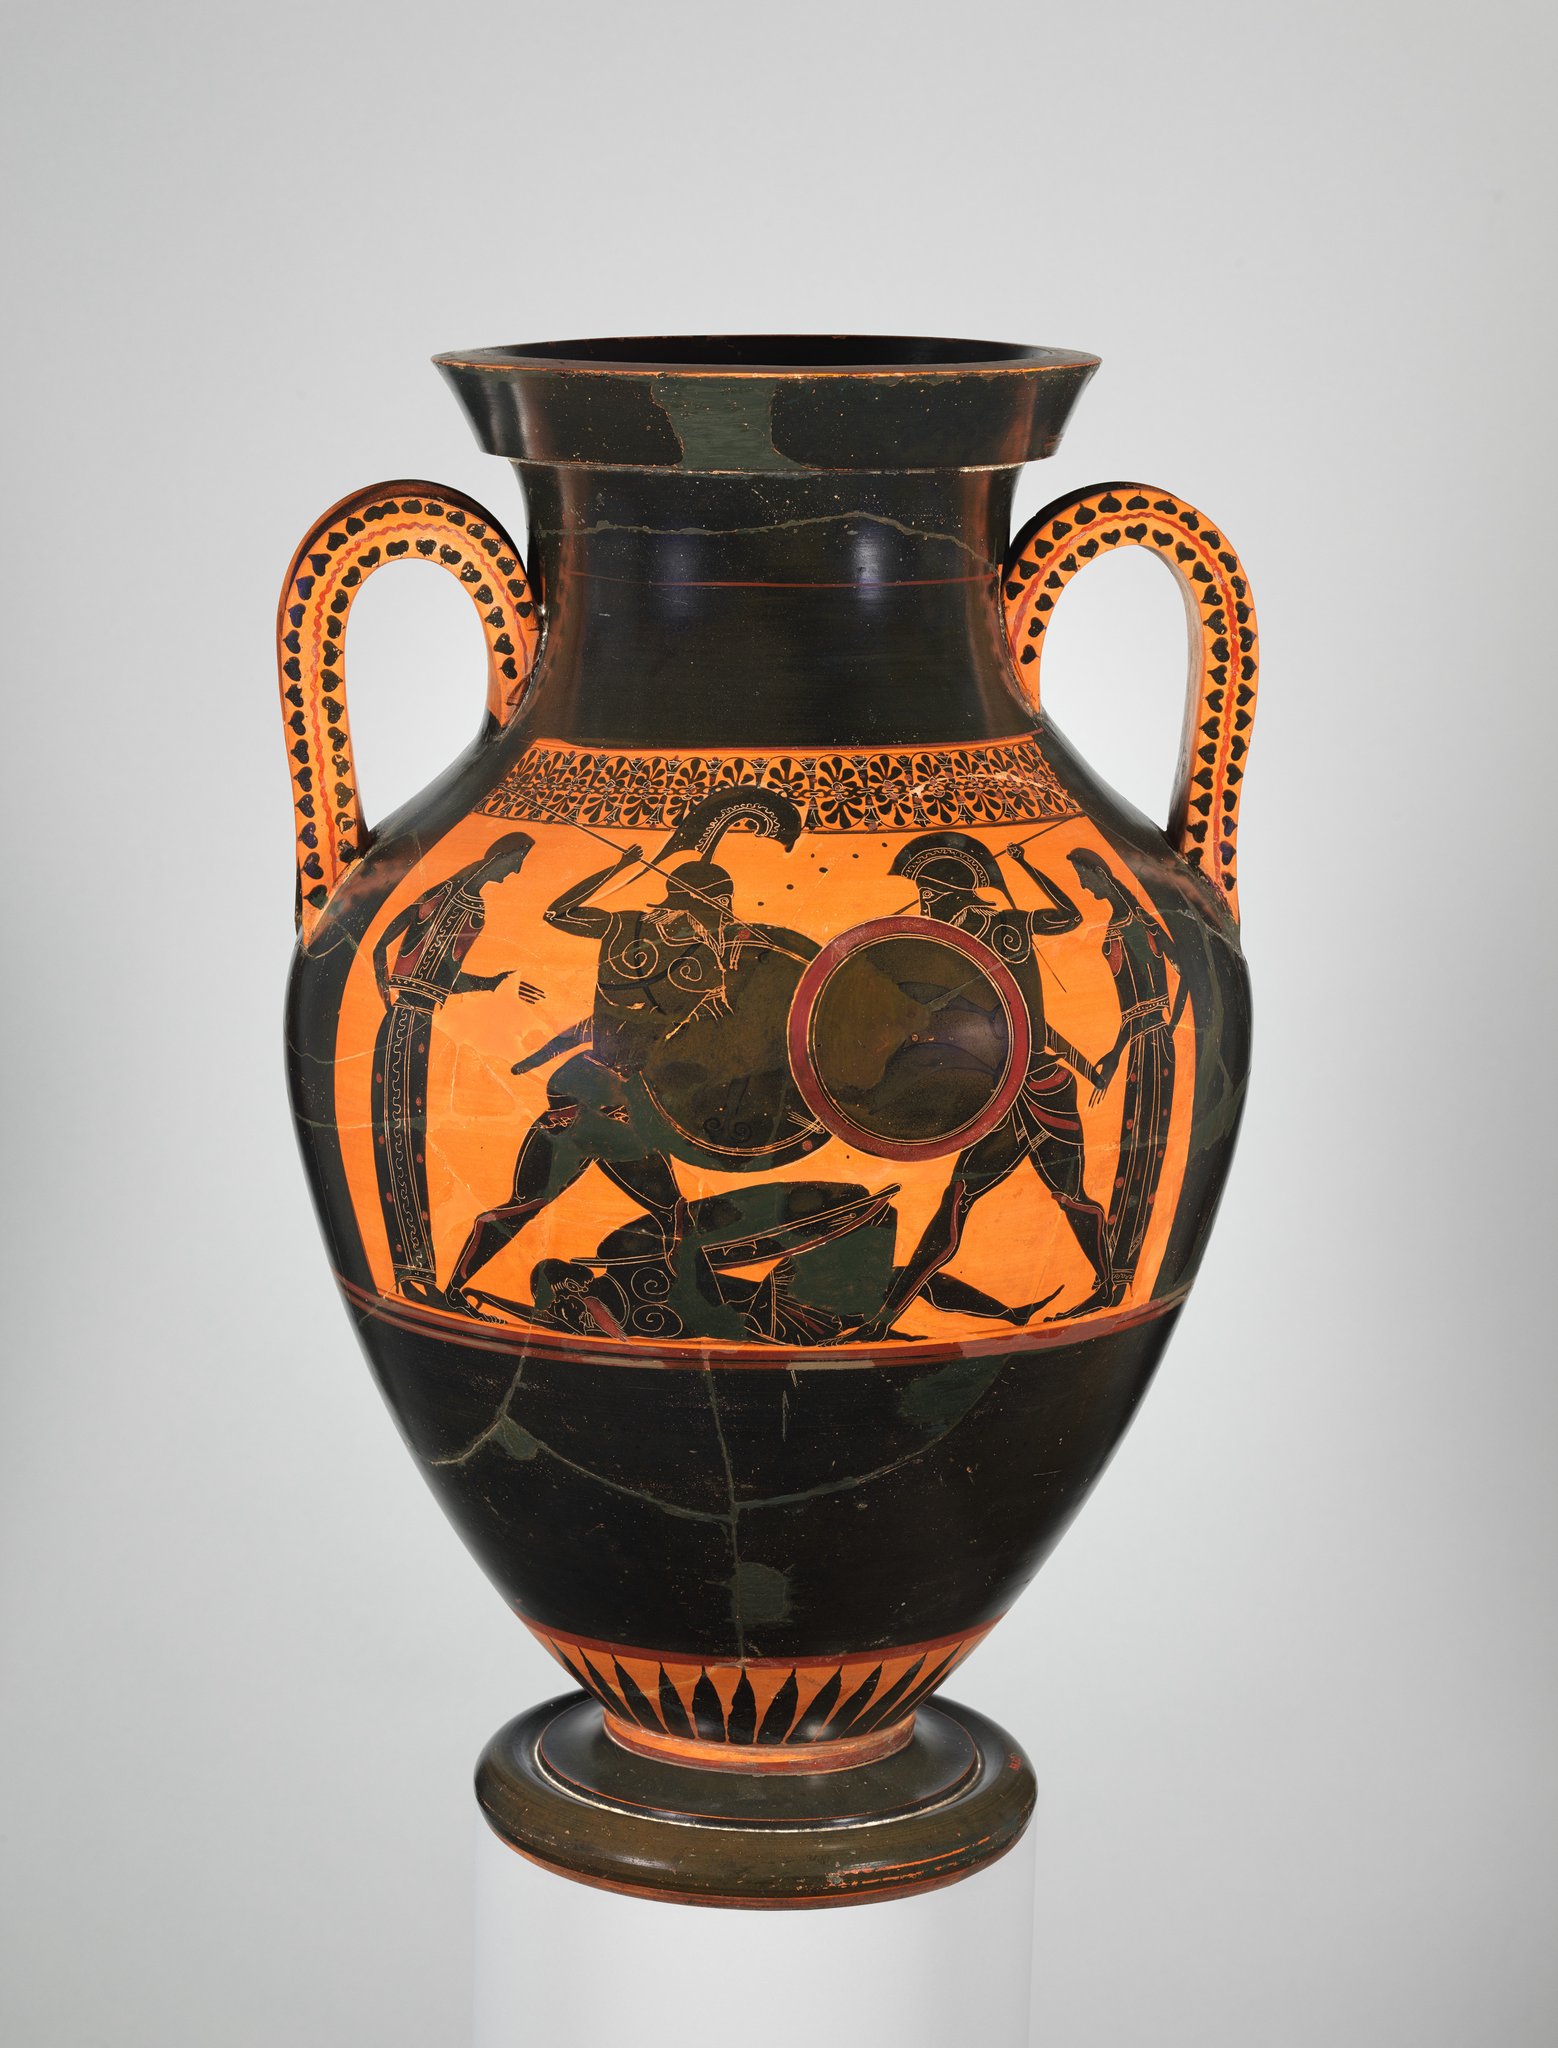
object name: amphora, type a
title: Terracotta amphora (jar)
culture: greek, attic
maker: lysippides painter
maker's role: artist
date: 520-510 BCE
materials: terracotta